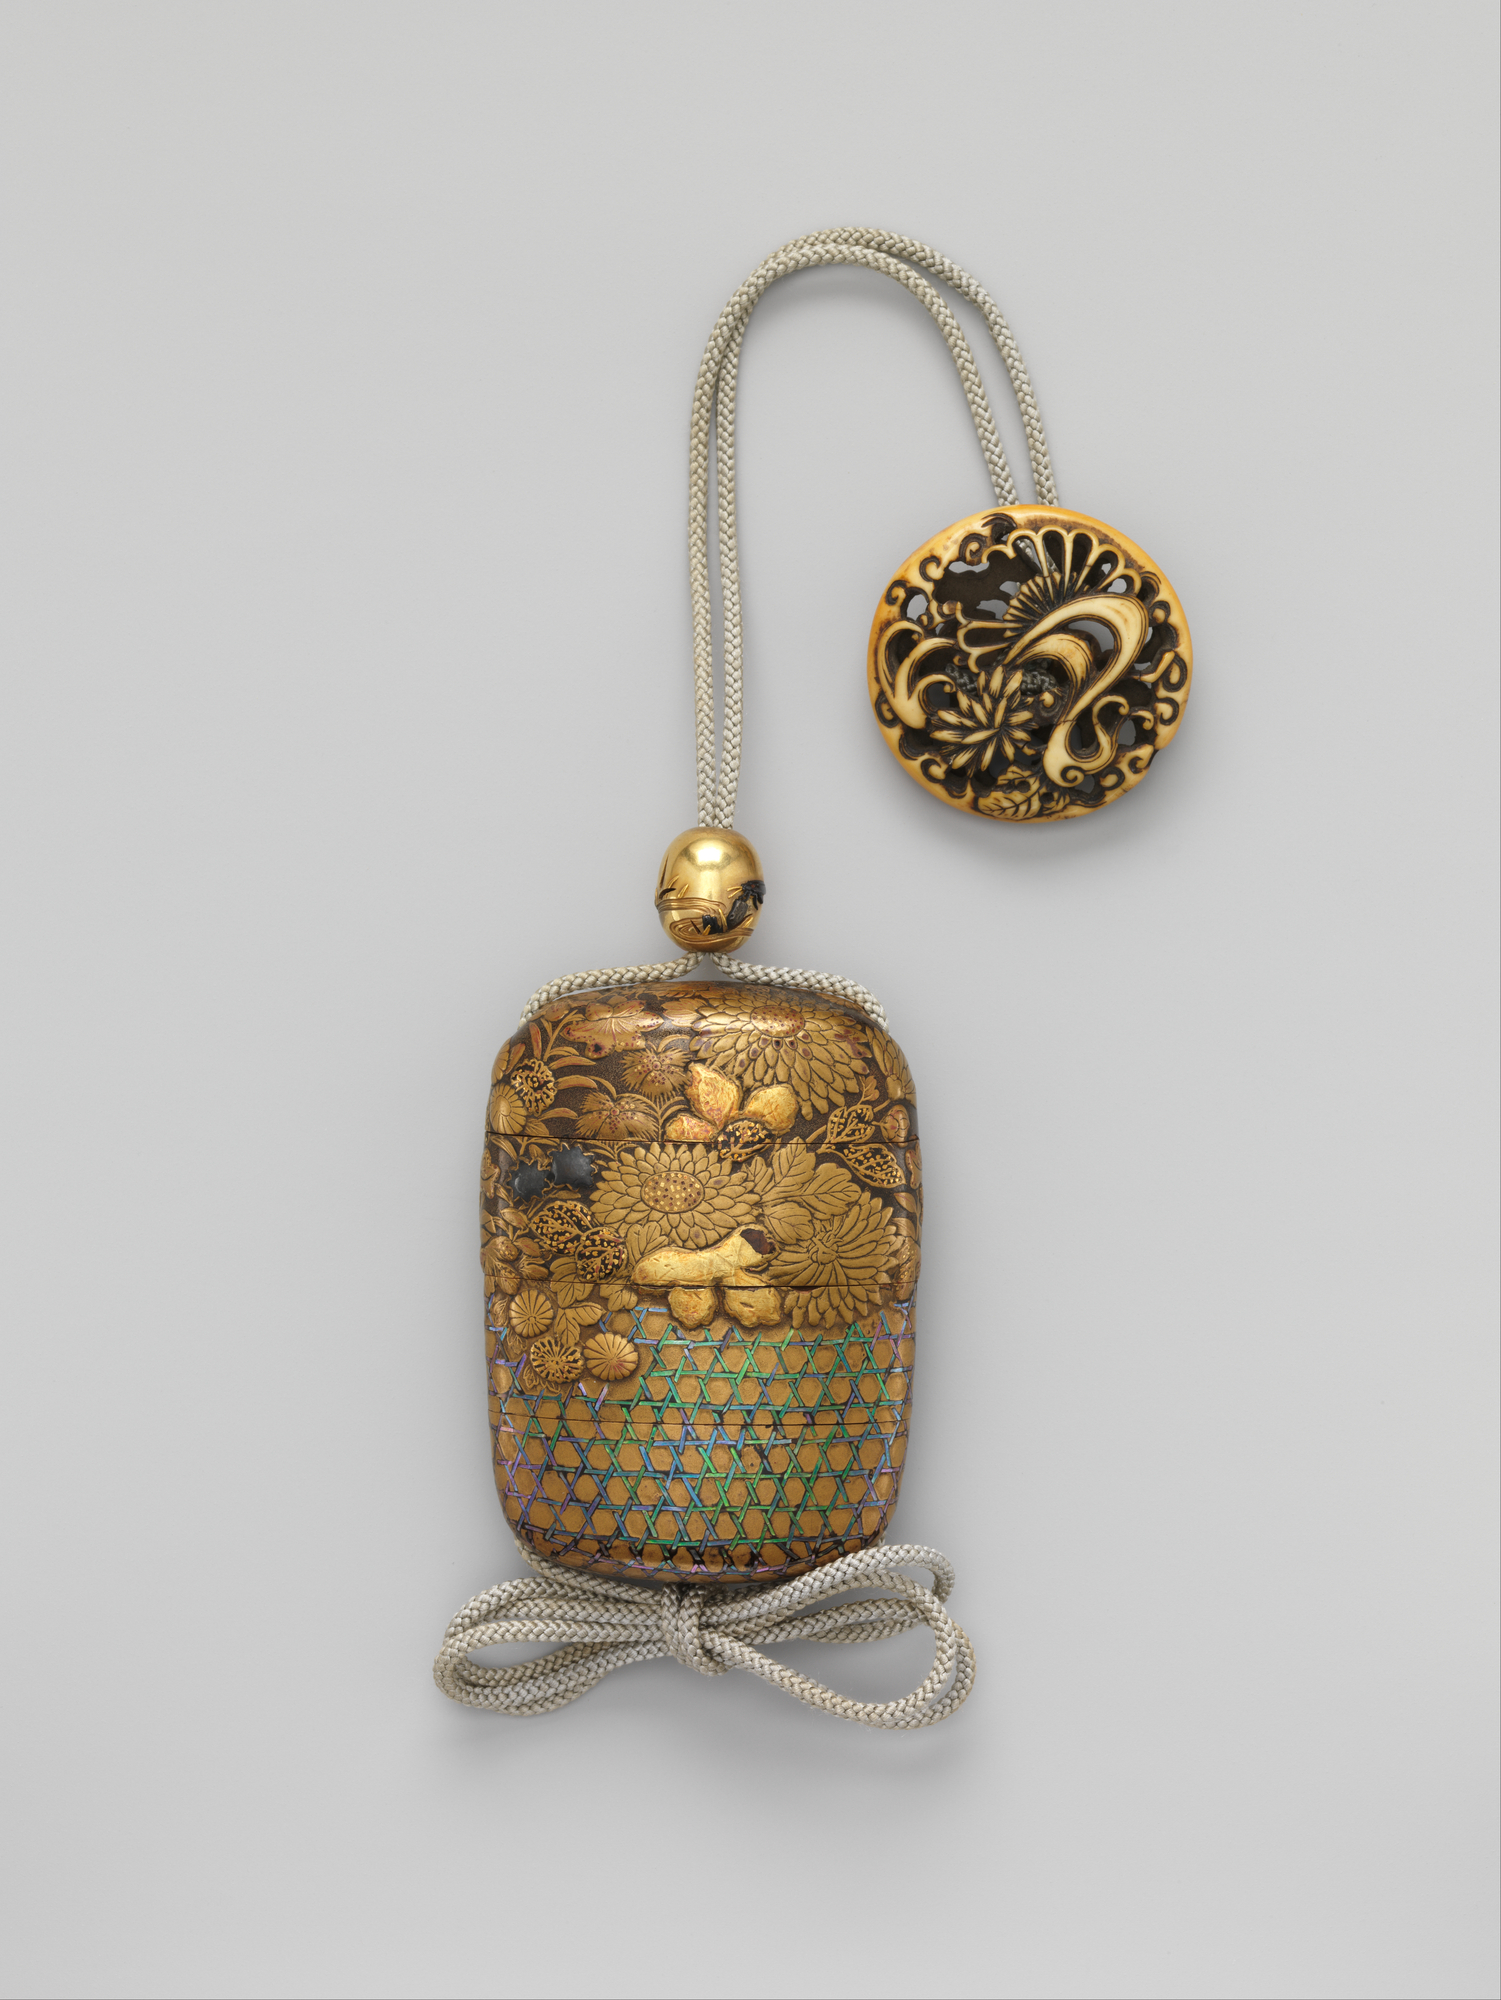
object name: inrō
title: Case (Inrō) with Chrysanthemum Decoration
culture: japanese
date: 1701-1900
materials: gold, mother of pearl, silver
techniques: inlay, lacquer, maki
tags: flowers